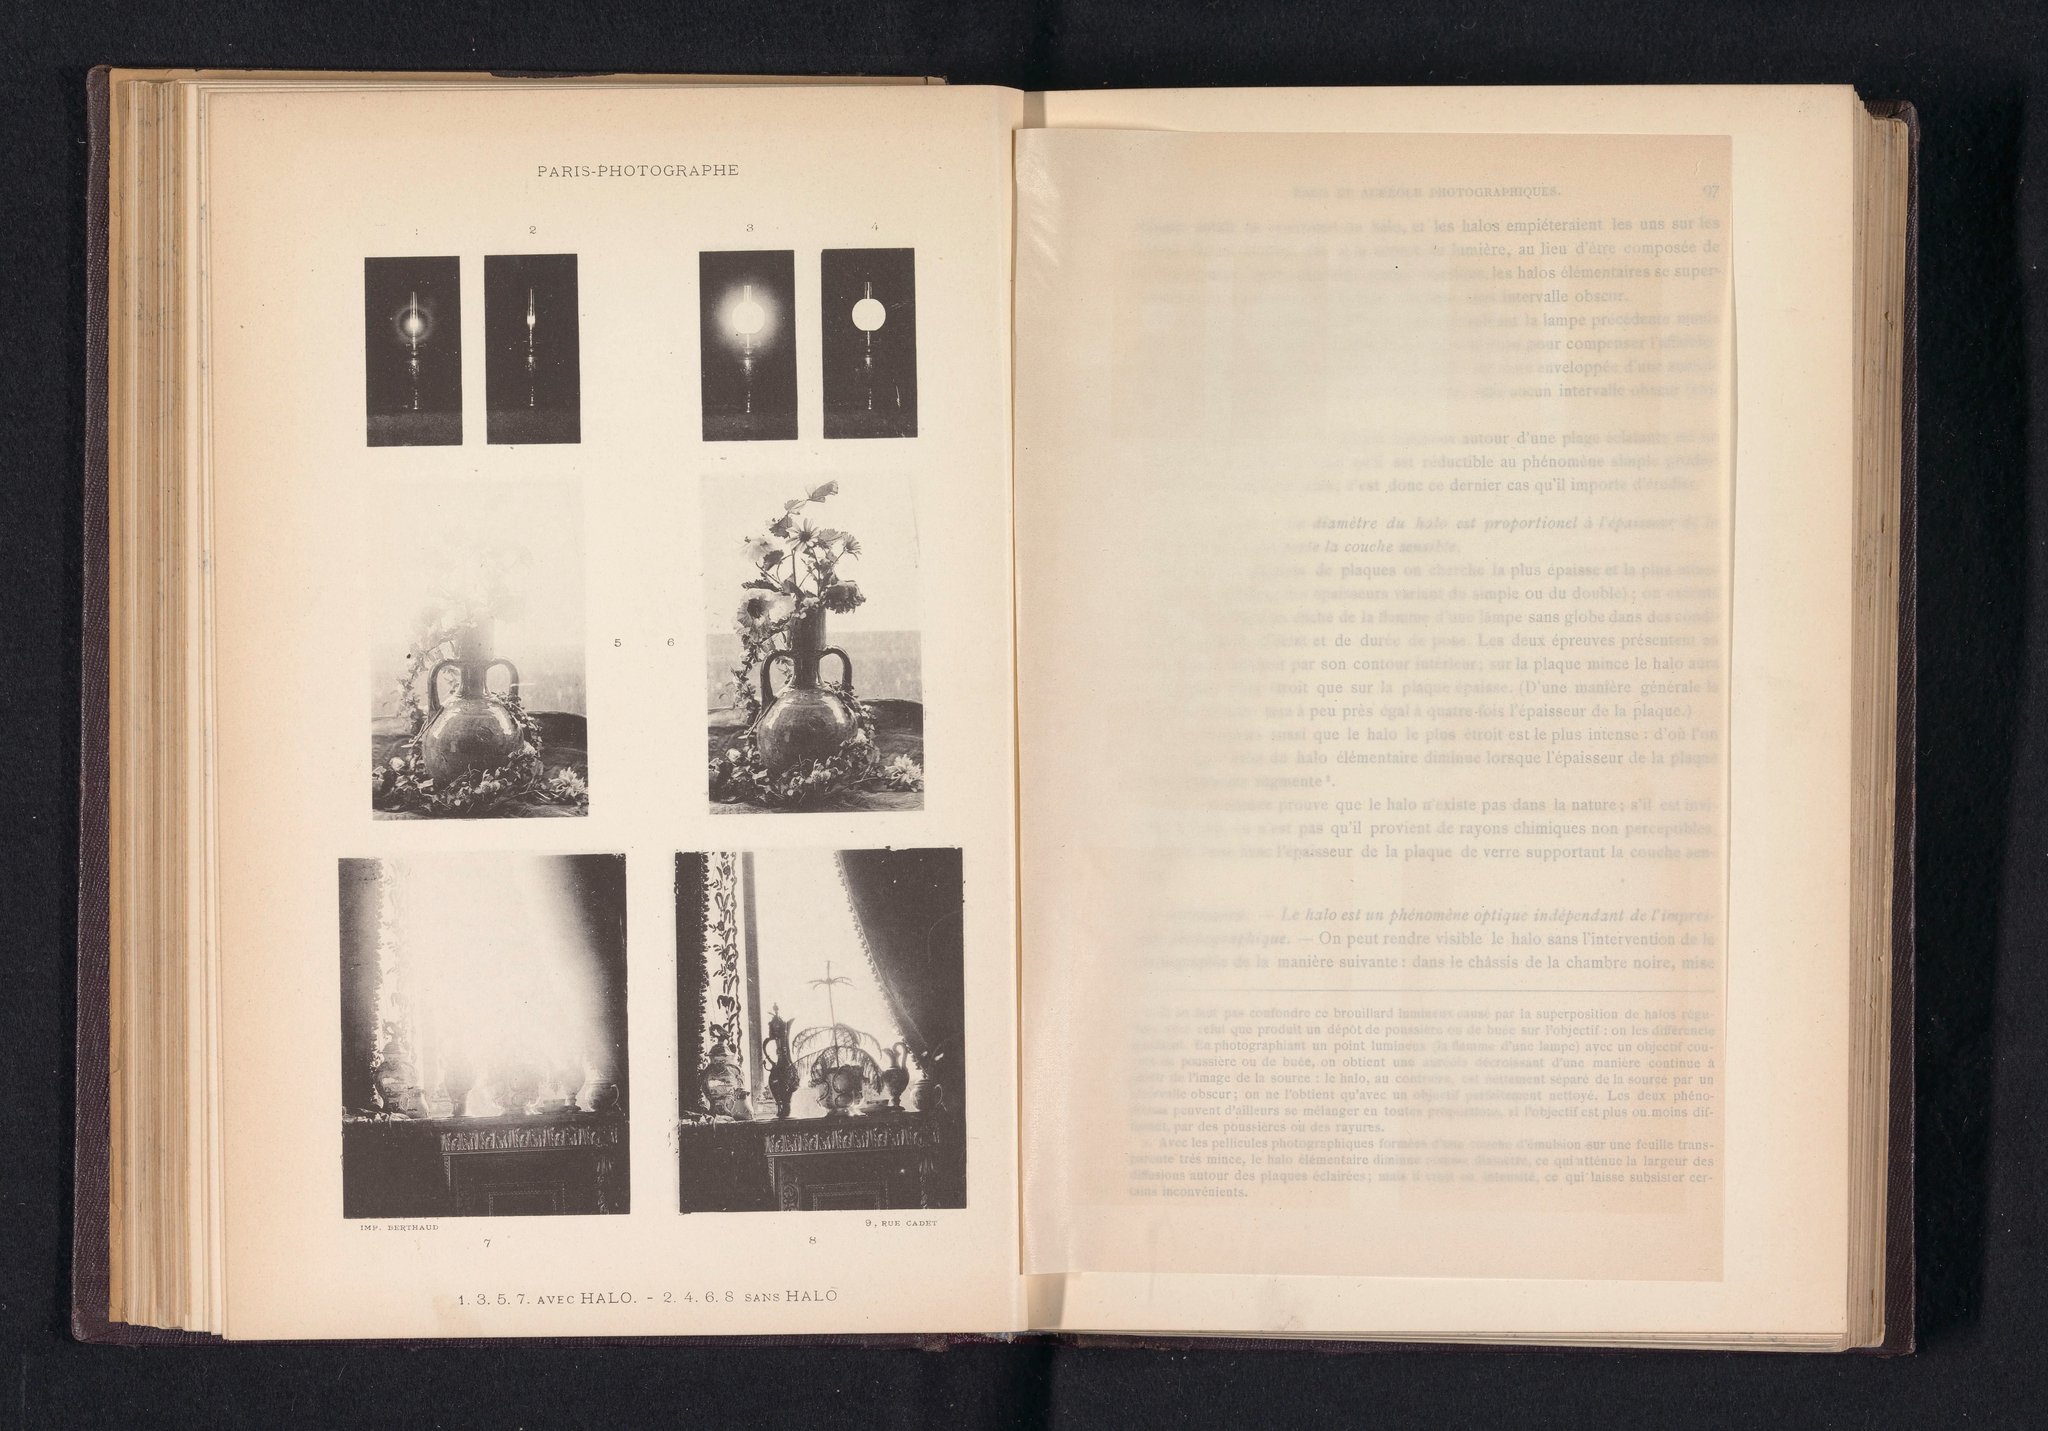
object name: photomechanical print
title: Acht opnamen van vier objecten met en zonder halo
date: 1881-1891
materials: paper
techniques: photograph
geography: paris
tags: nimbus, halo ~ radiance emanating from persons or things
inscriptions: inscription: ‘1.3.5.7. avec Halo. - 2.4.6.8 sans Halo.’